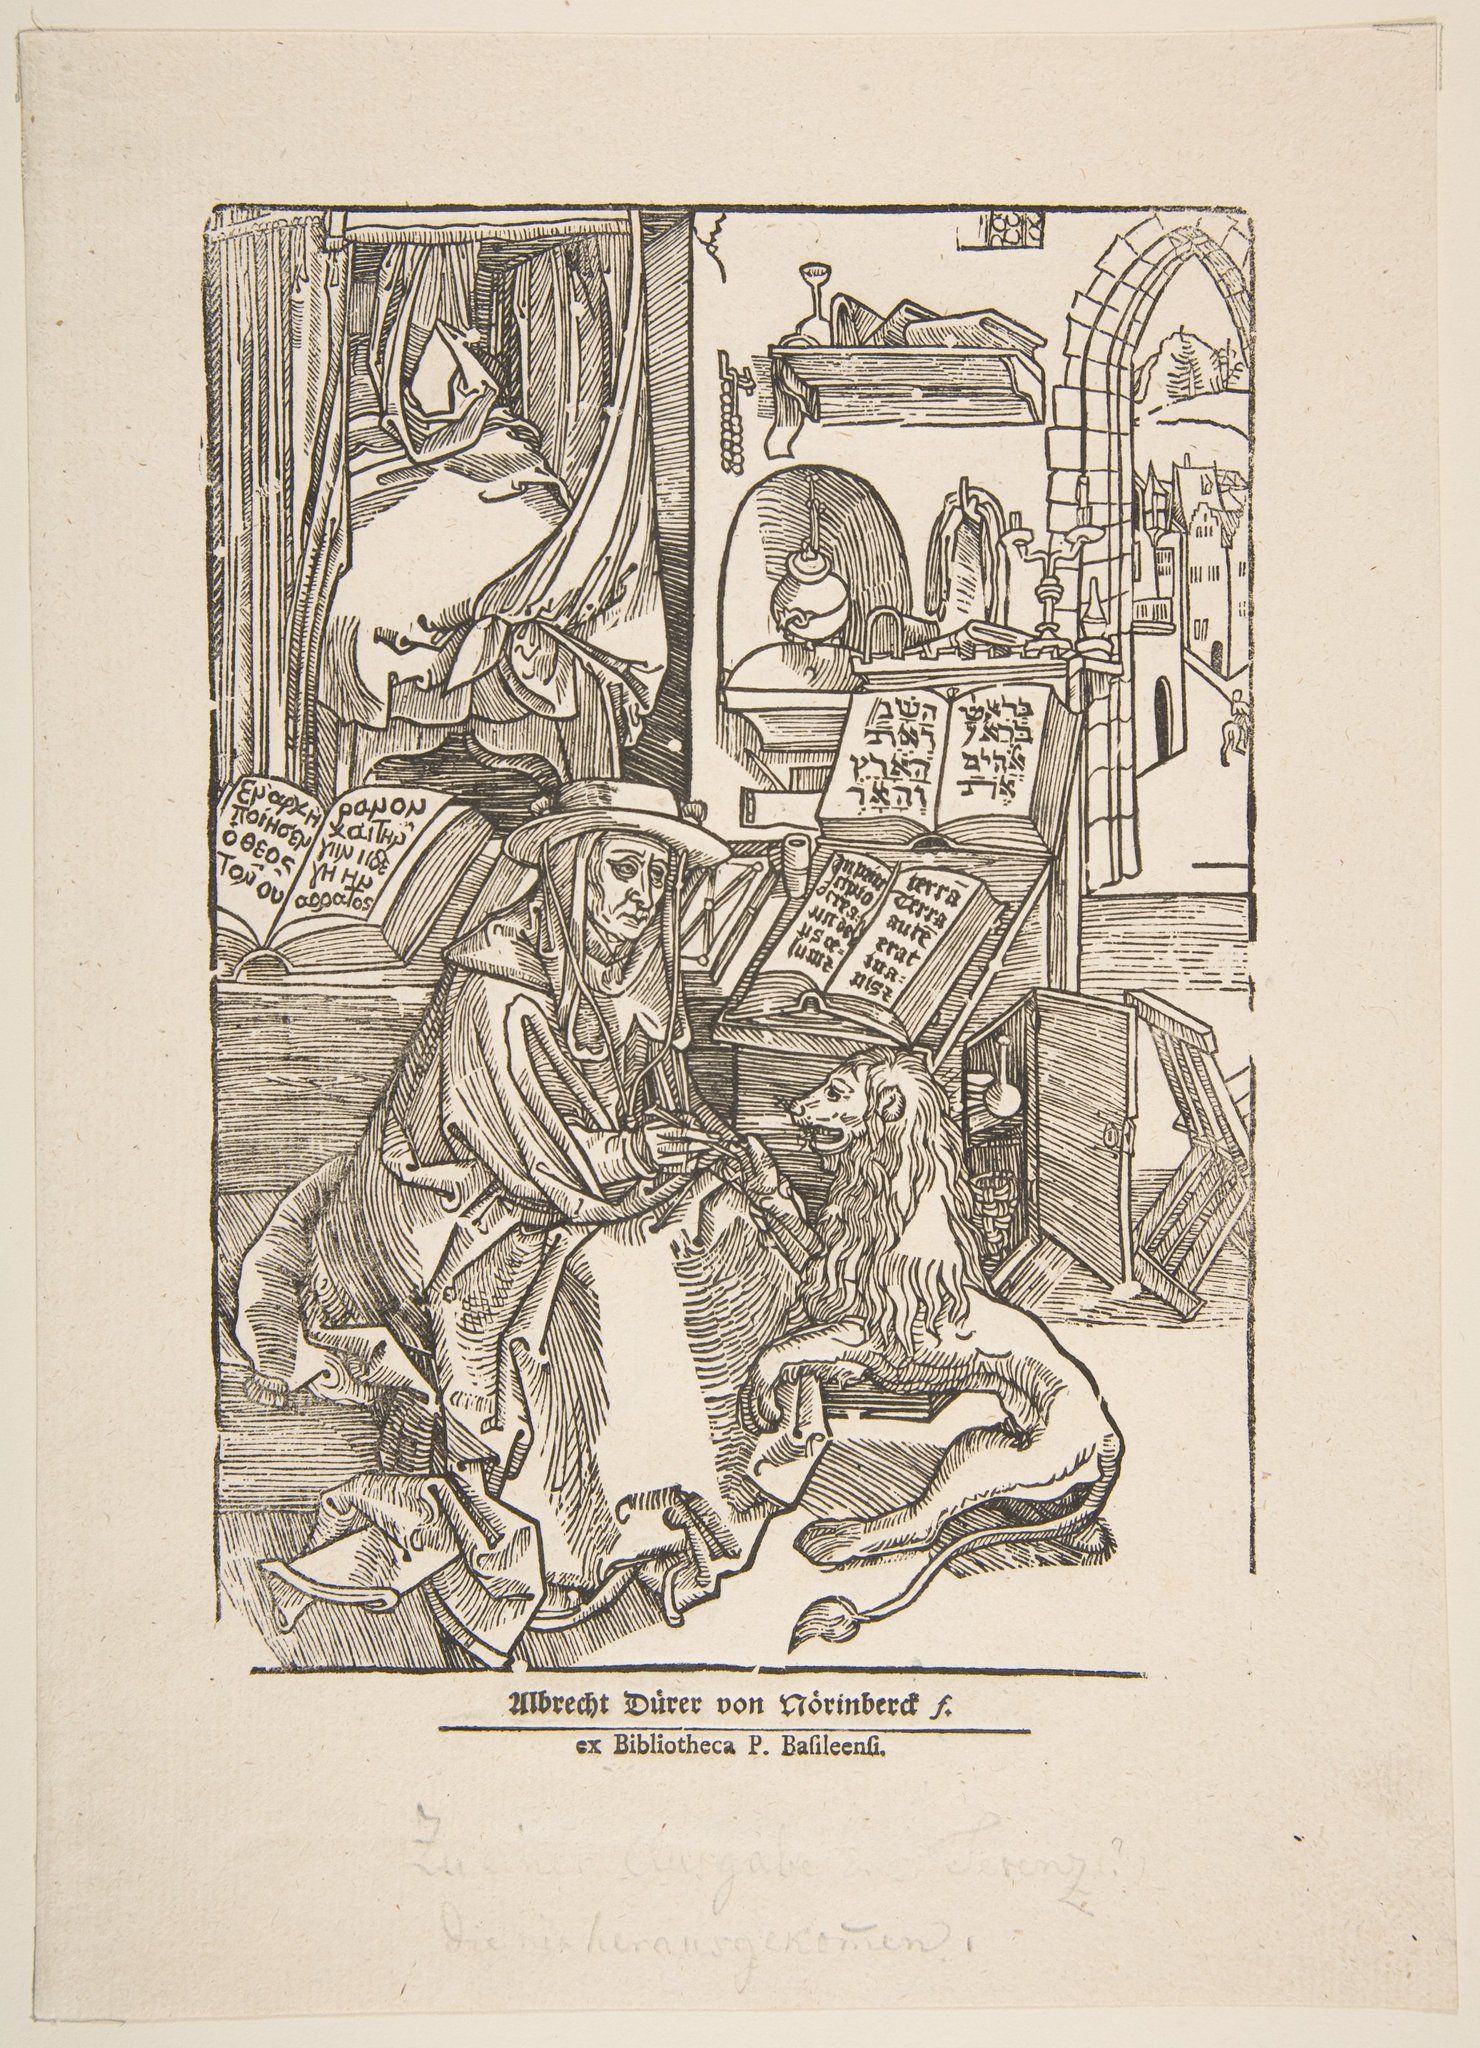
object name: print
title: Saint Jerome Extracting a Thorn from the Lion's Foot, 19th century reprint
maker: albrecht dürer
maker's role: artist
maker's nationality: german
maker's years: 1471-1528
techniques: woodcut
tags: books,lions,saint jerome